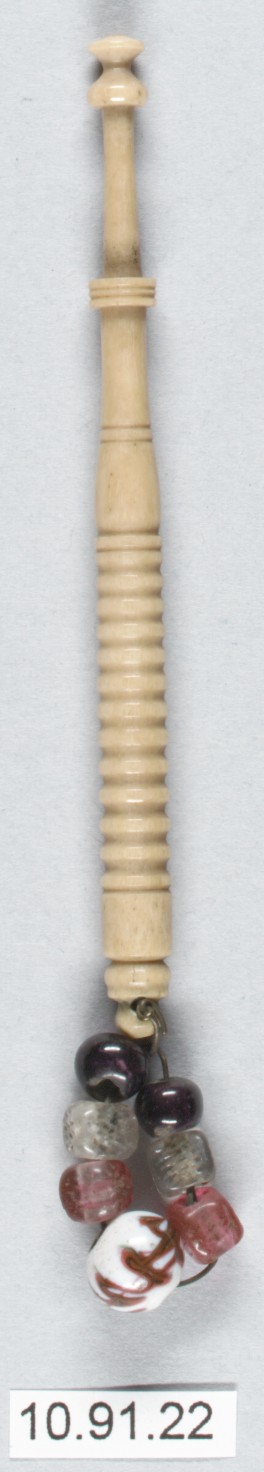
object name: bobbin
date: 1801-1900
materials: bone